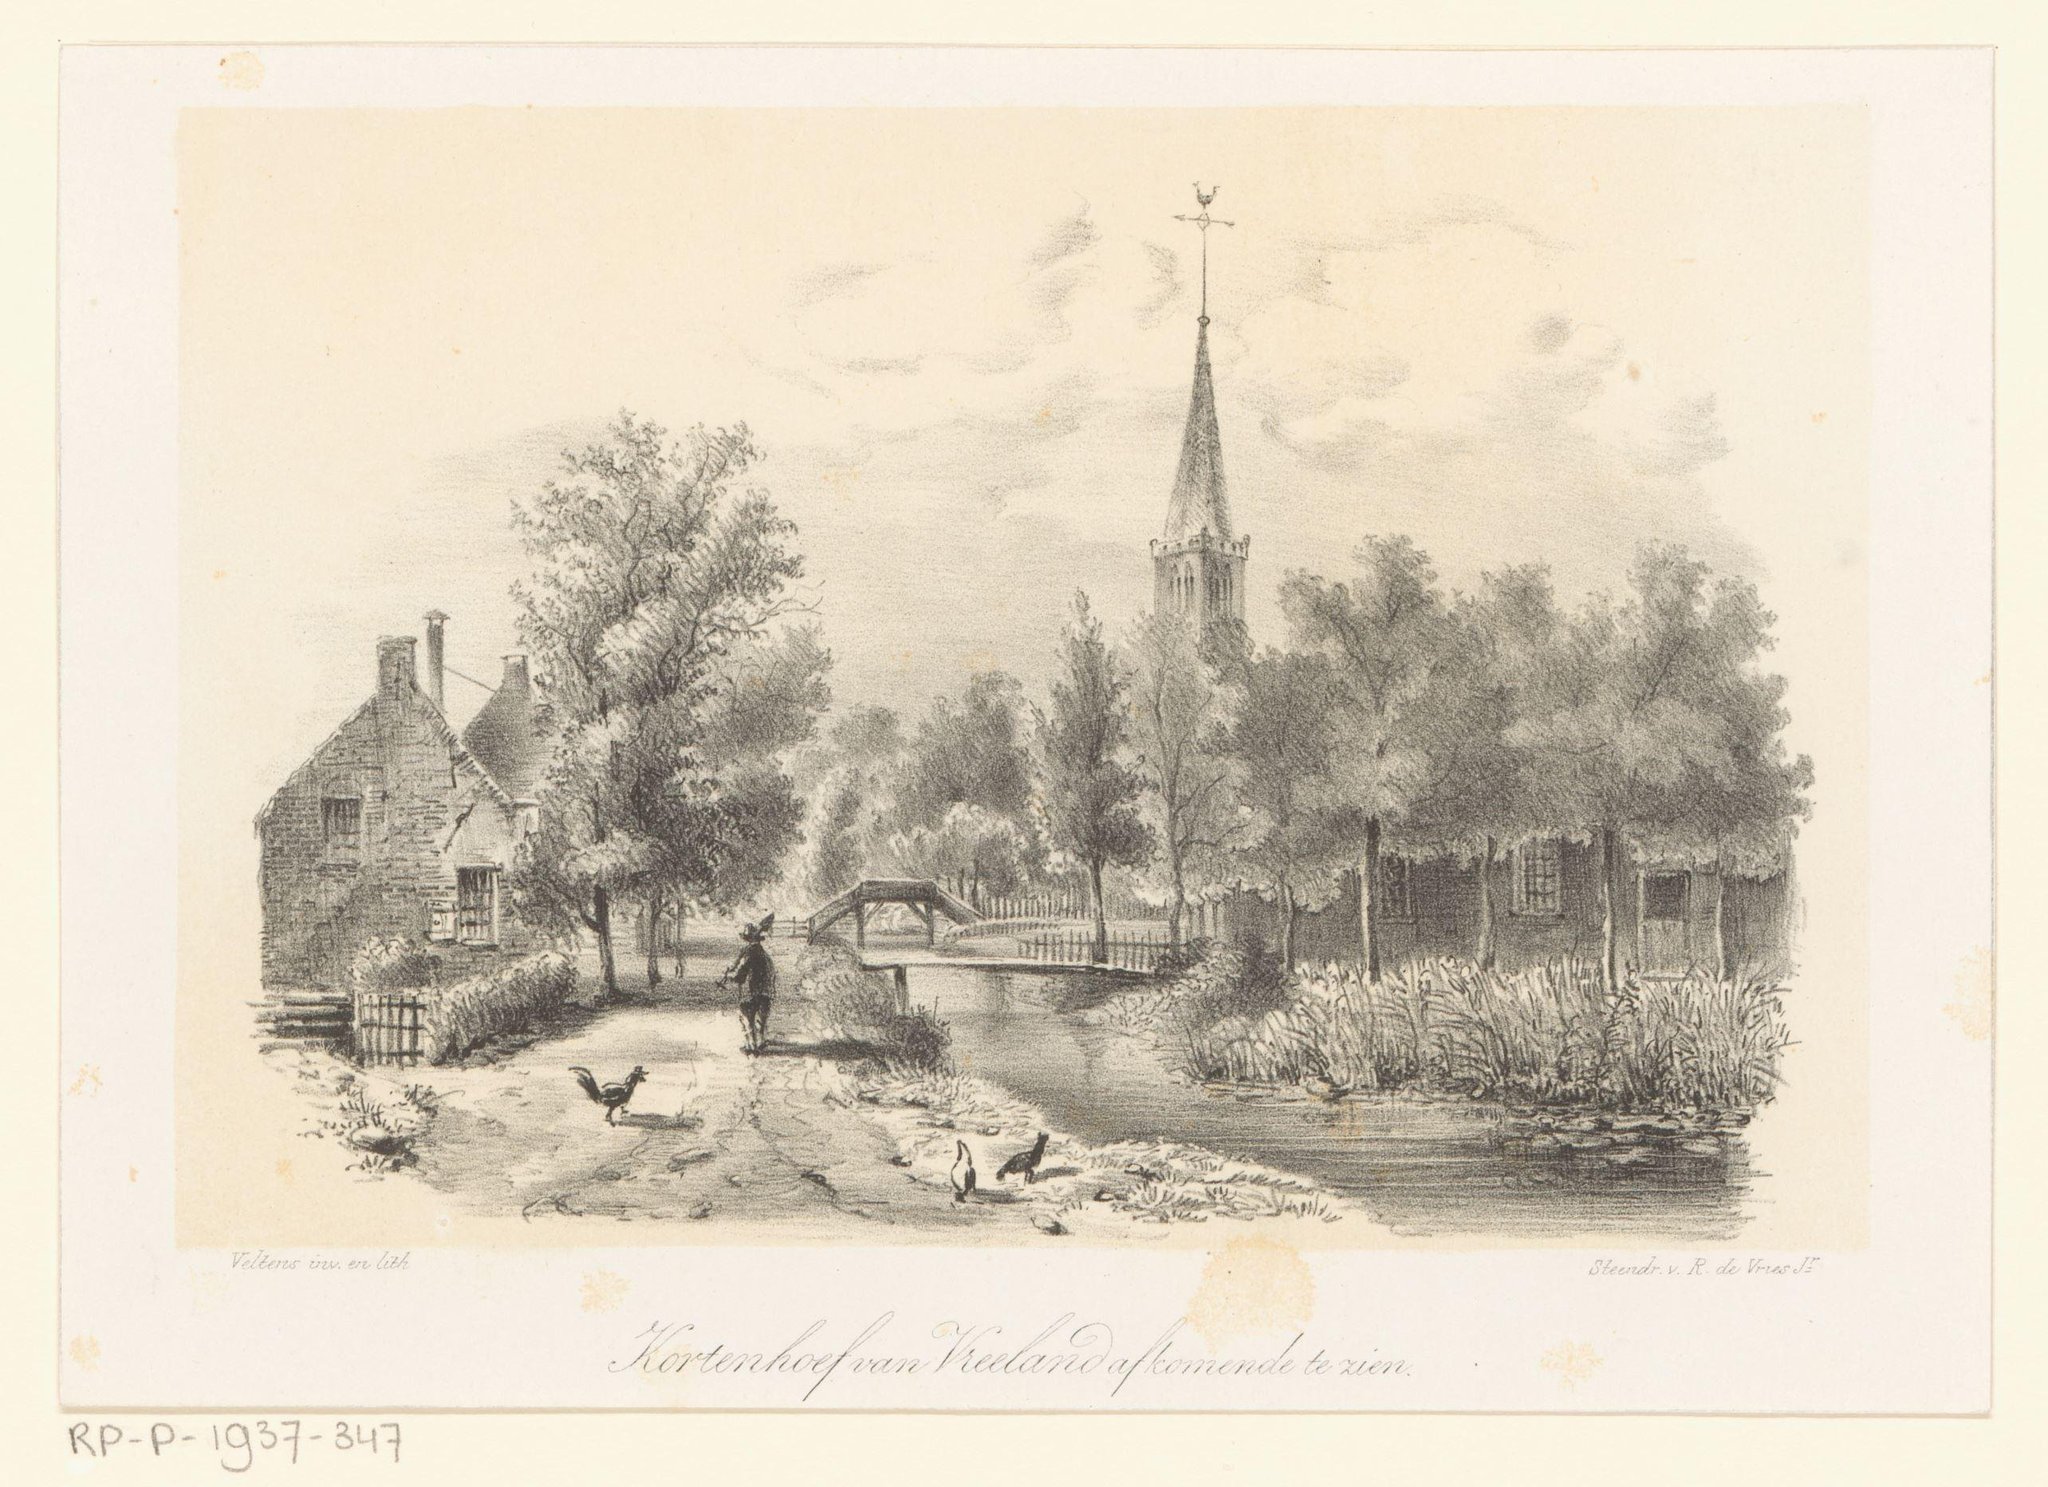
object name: print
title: Kortenhoef van Vreeland afkomende te zien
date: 1824-1874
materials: paper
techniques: tone lithography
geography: netherlands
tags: village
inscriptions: collector's mark: Lugt 2760, collector's mark: Lugt 2228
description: Gezicht op het dorp Kortenhoef met bruggen over het water en in de achtergrond de kerktoren.